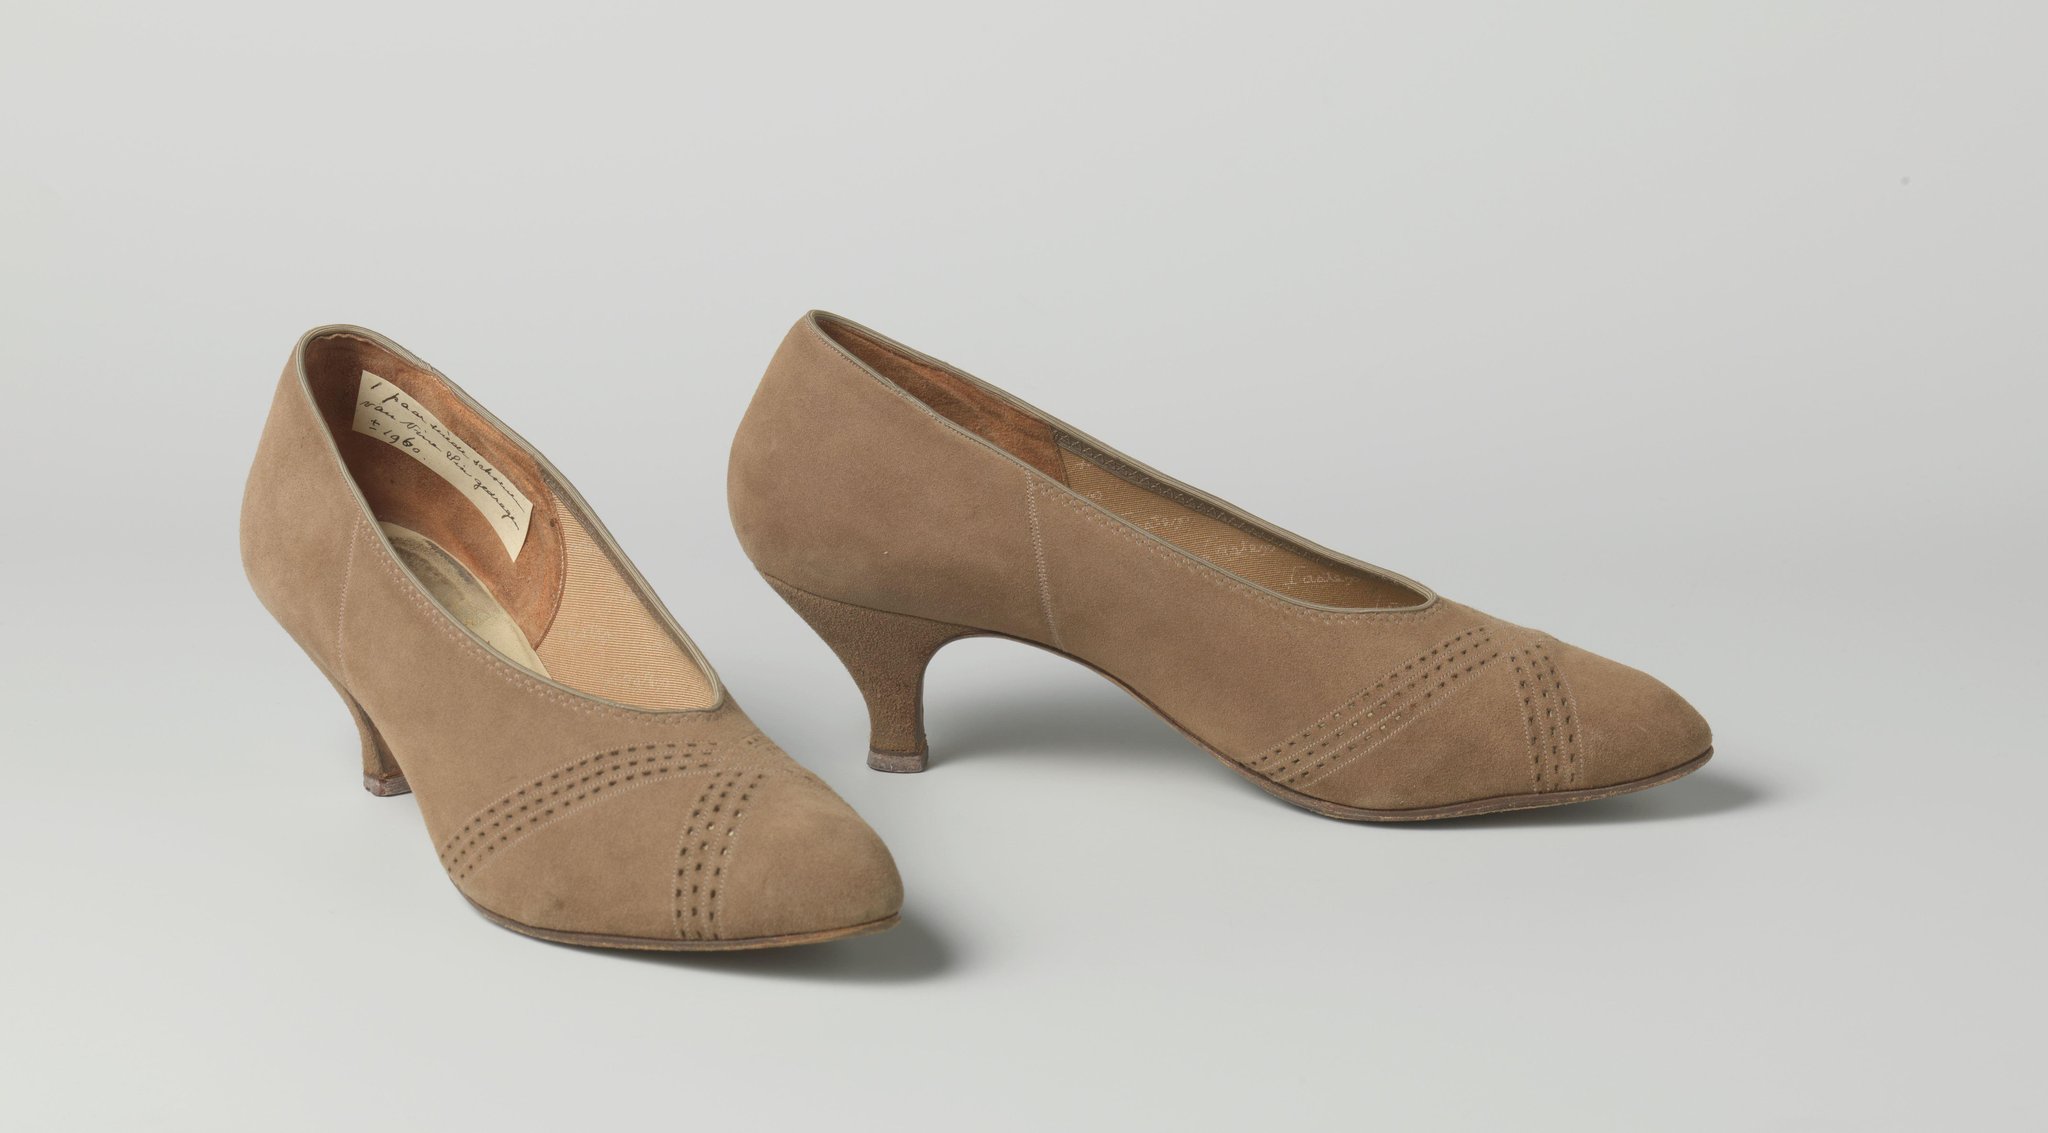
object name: pump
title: Schoen, pump van beige peau de suède, geperforeerde kruislingse banden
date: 1960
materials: leather, textile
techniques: perforating, quilting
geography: hilversum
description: Linkerschoen, pump van beige peau de suède. Scherpe punten. Uit één stuk leer, 'pompadour' hak, de punt in een beginstadium van de naaldhak. Ter versiering perforaties in de twee kruislingse doorgestikte banden over de voet. Zool van leer. Voering van rayon en bij de hiel opgeruwd leer.